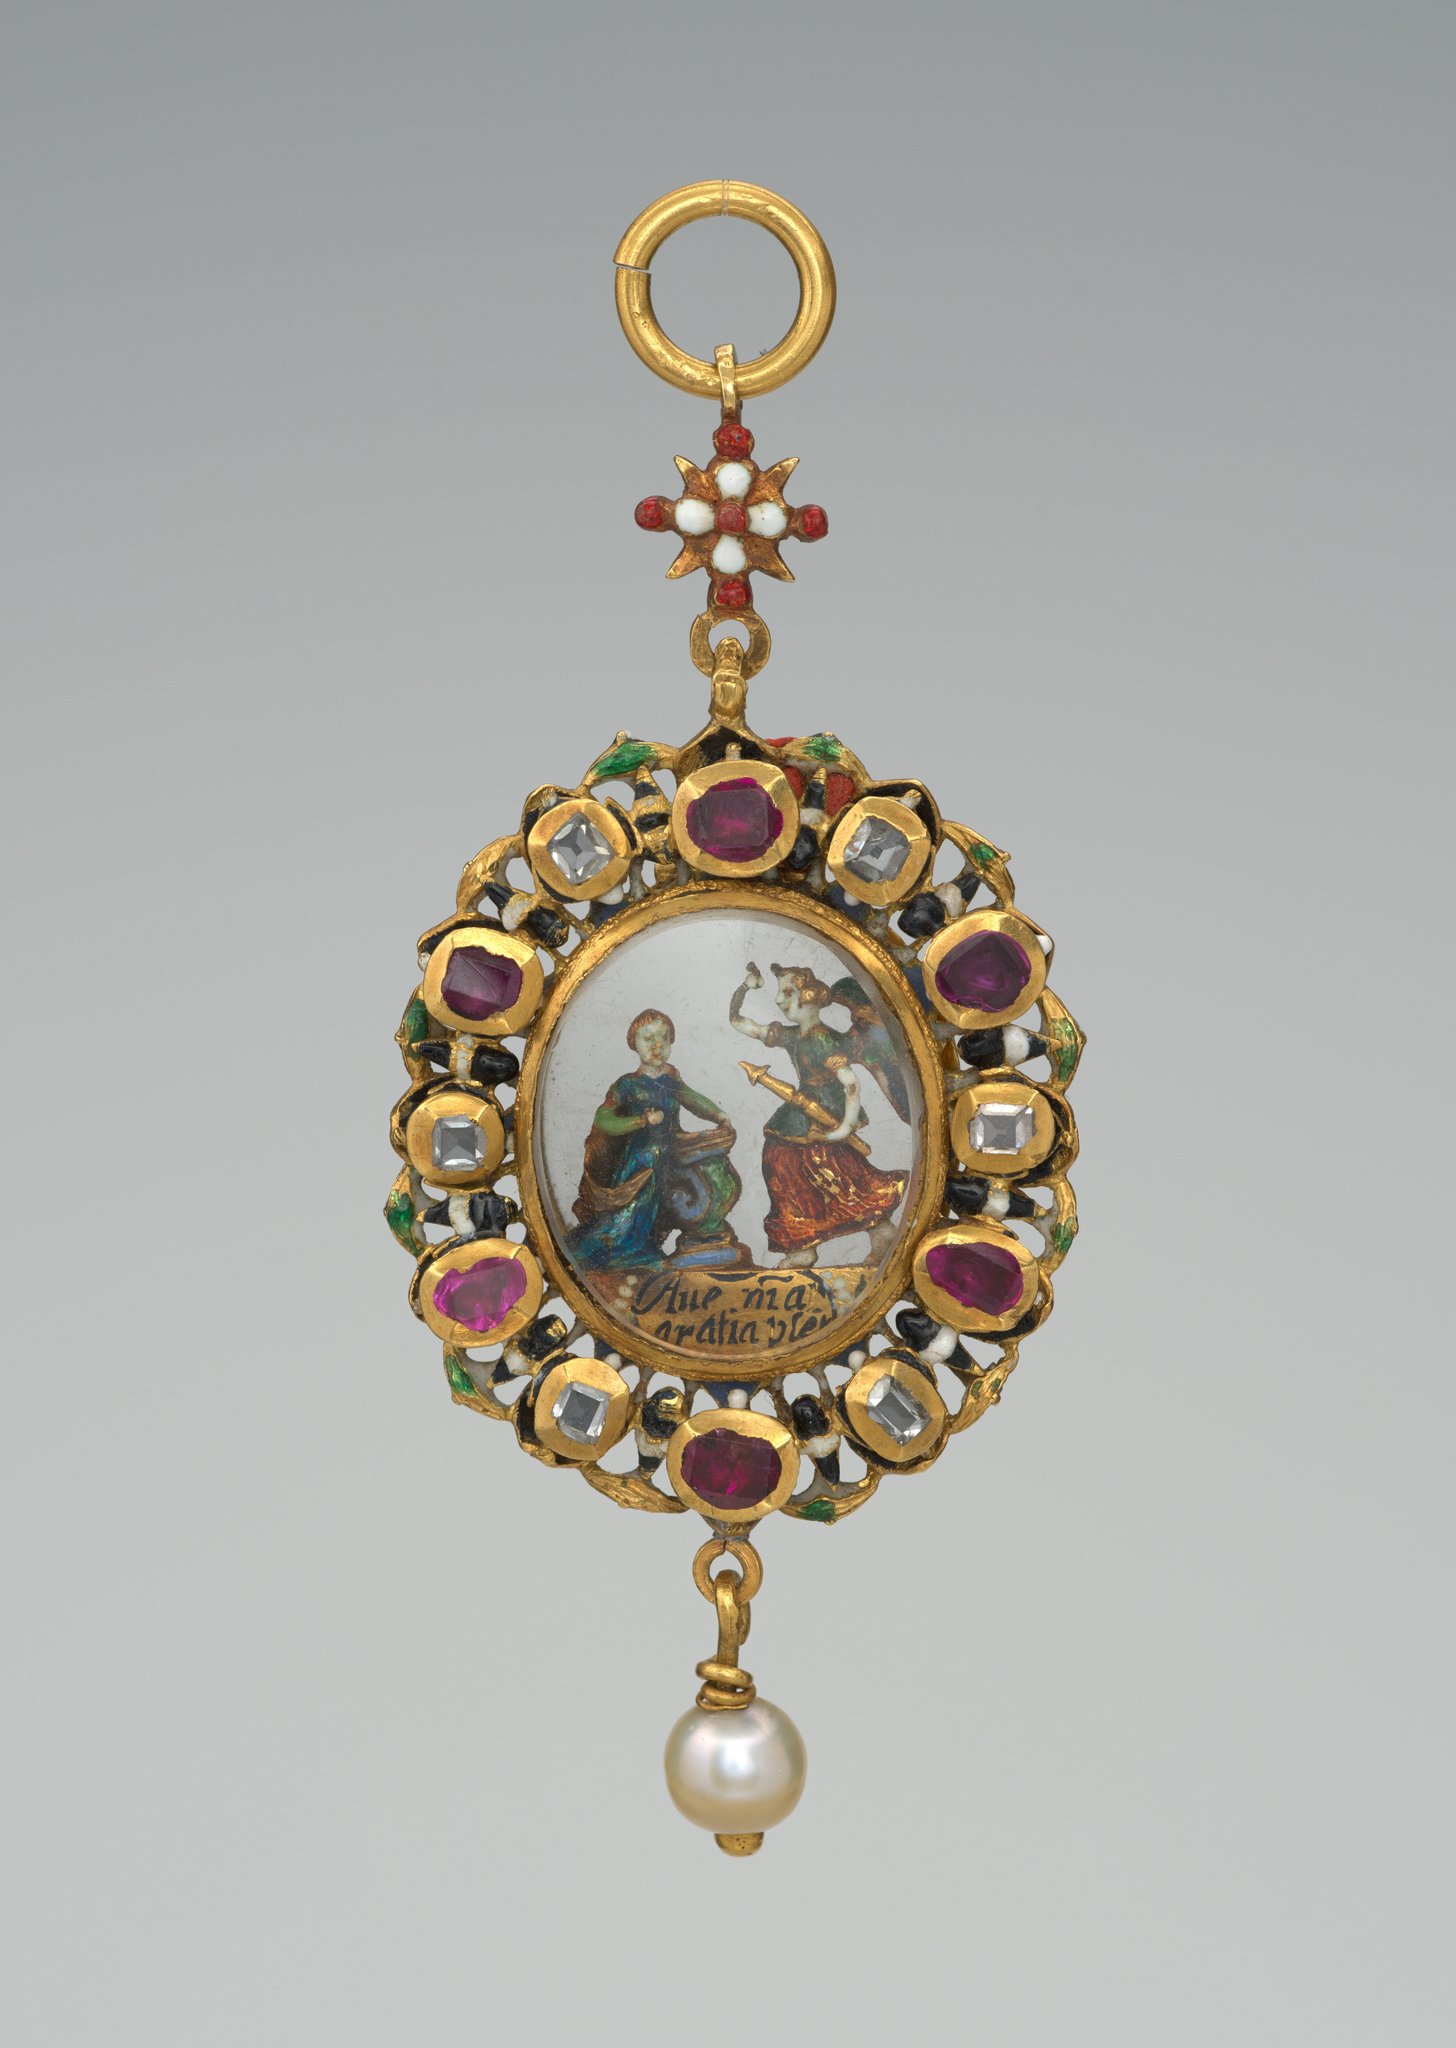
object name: reliquary pendant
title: Pendant reliquary with depiction of the Annunciation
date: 1601-1700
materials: crystal, enamel, gold, pearl, quartz, gemstone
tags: angels,annunciation